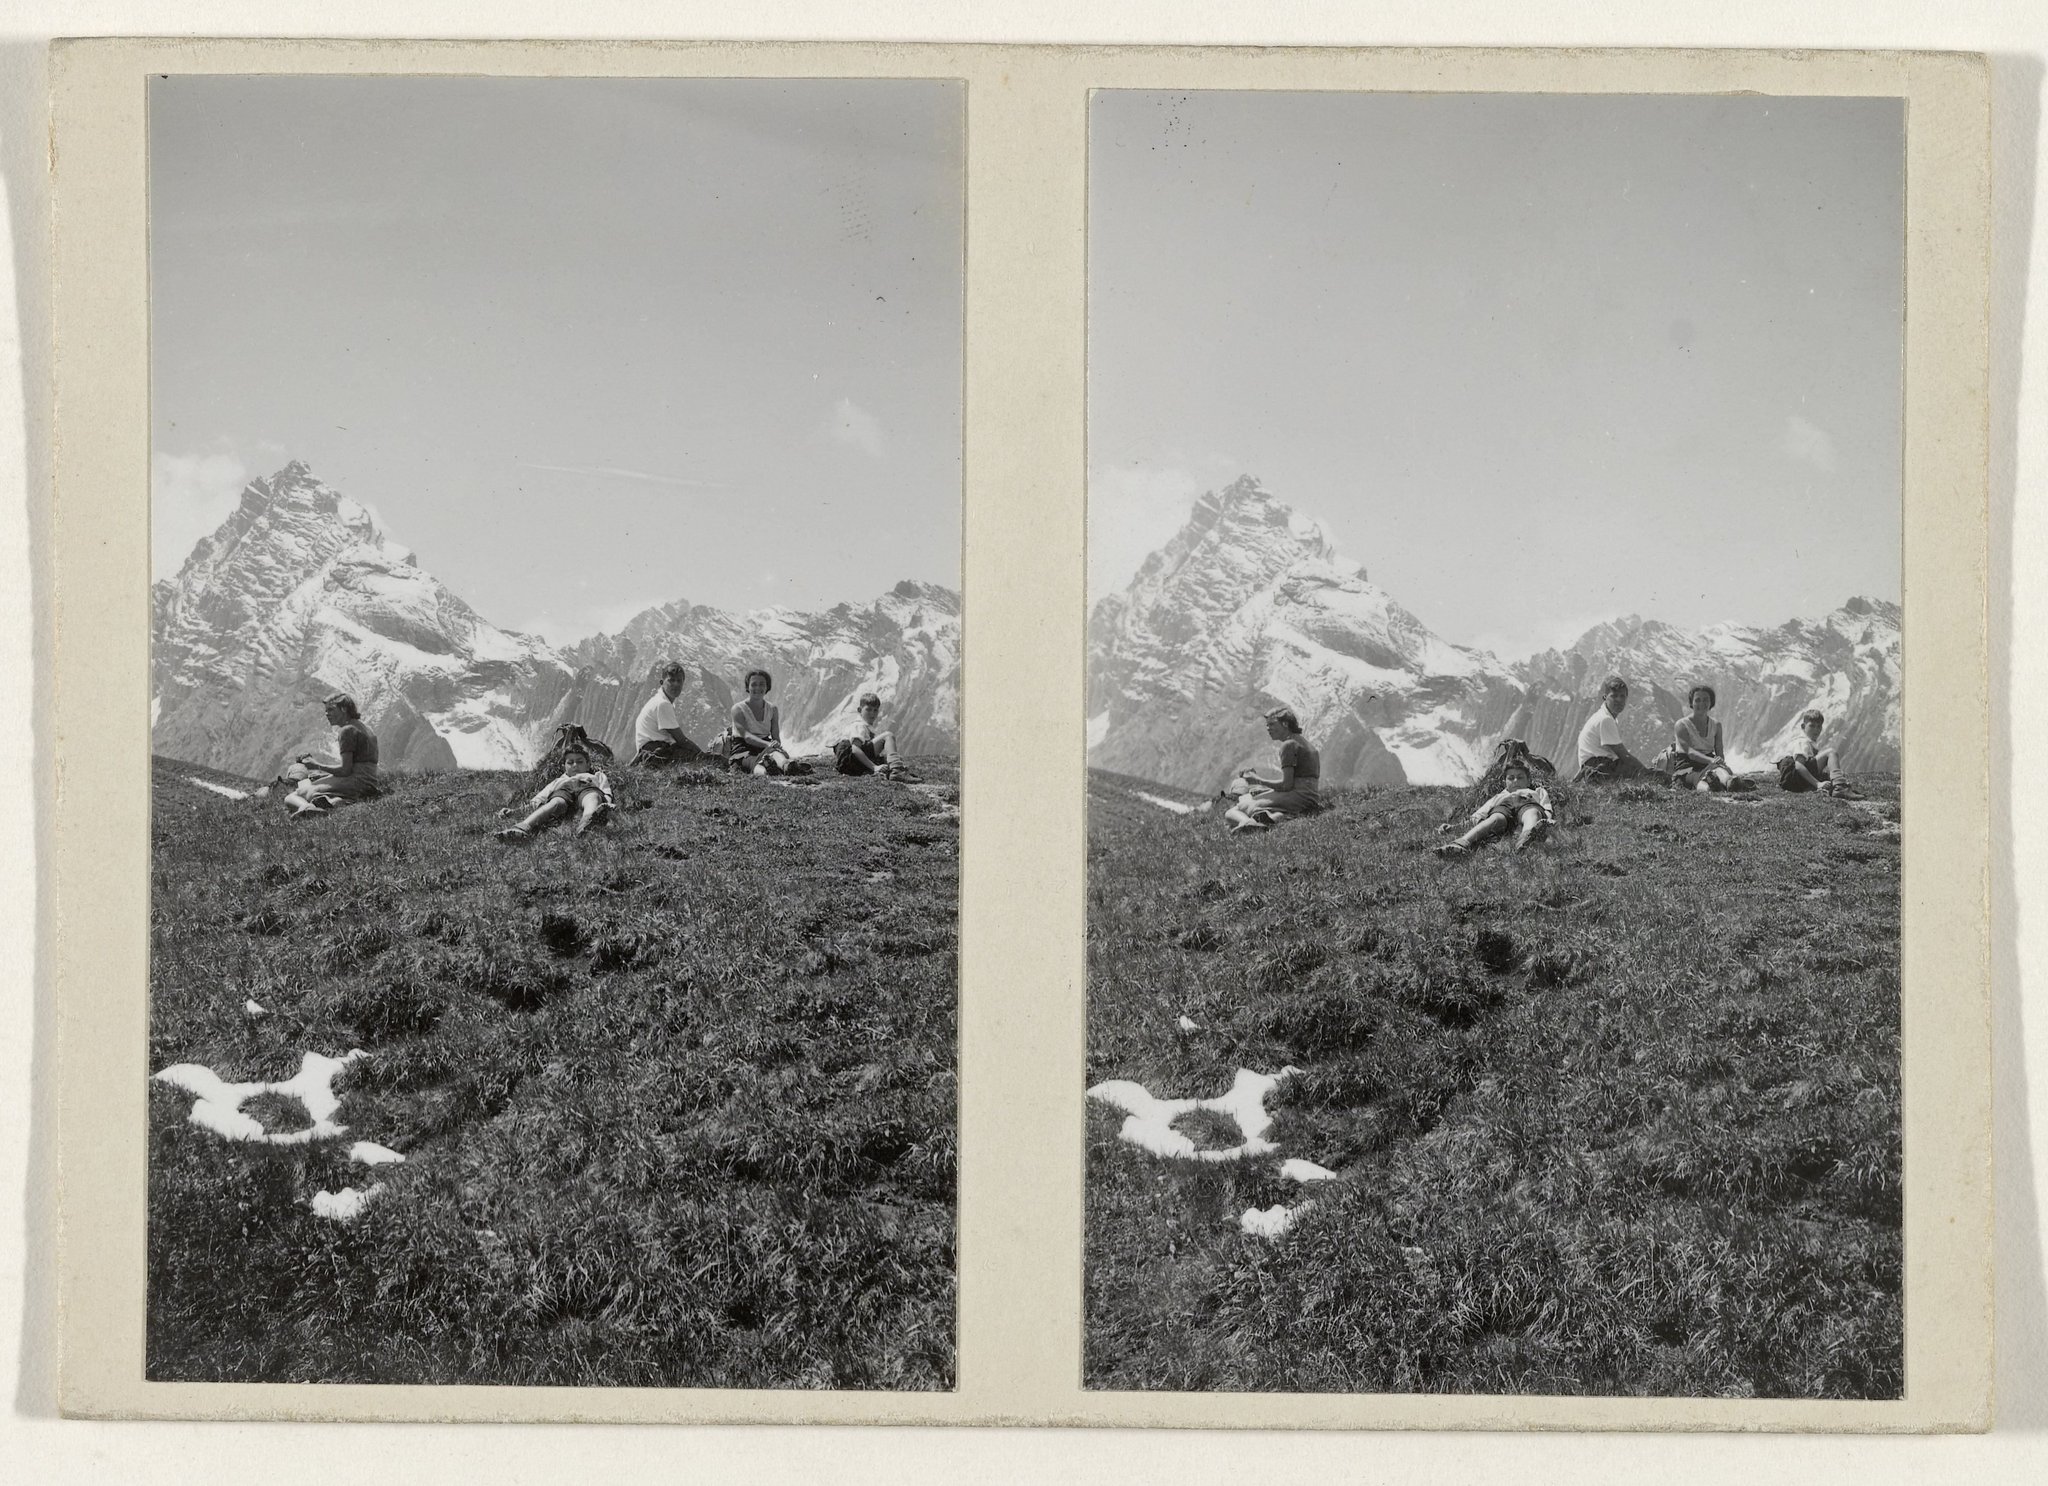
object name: stereograph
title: Rustende mensen op een grasveld temidden van besneeuwde heuveltoppen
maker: geldolph adriaan kessler (dolph)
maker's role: fotograaf, industrieel, voetballer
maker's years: 1884-1945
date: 1920-1945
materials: paper, photographic support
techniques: collodion silver print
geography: netherlands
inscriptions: title: ‘De Tinzen kom van af het colletje N. van de Pizdela.’